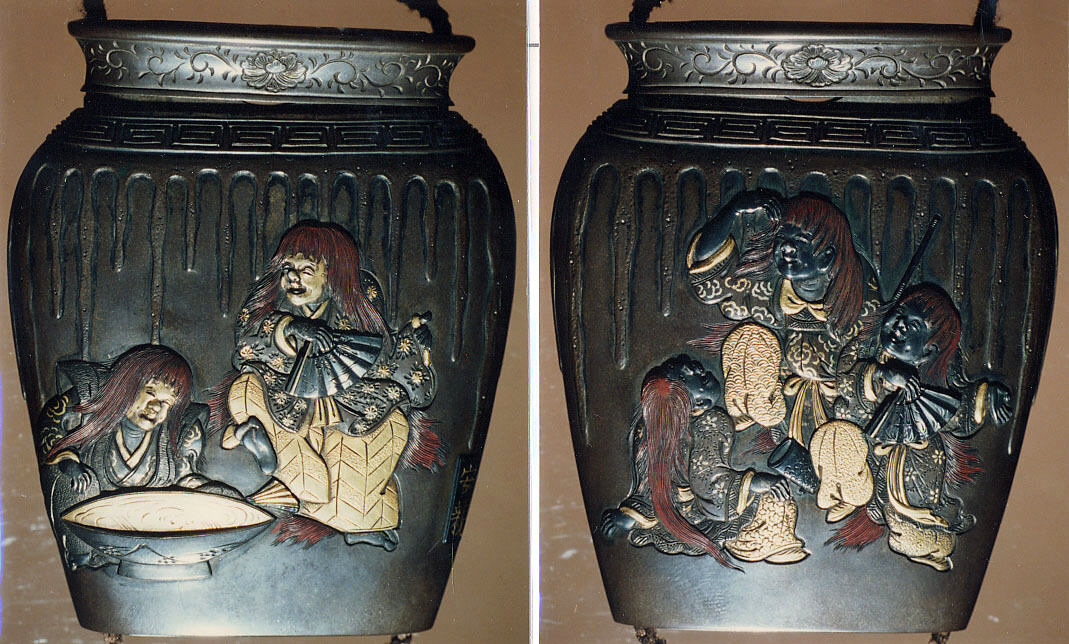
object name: inrō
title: Case (Inrō) with Design of Five Dancers Drinking from Large Sake Jar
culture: japanese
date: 1867-1900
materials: gold, metal, metal alloy, silver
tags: fans,men,drinking,dancers